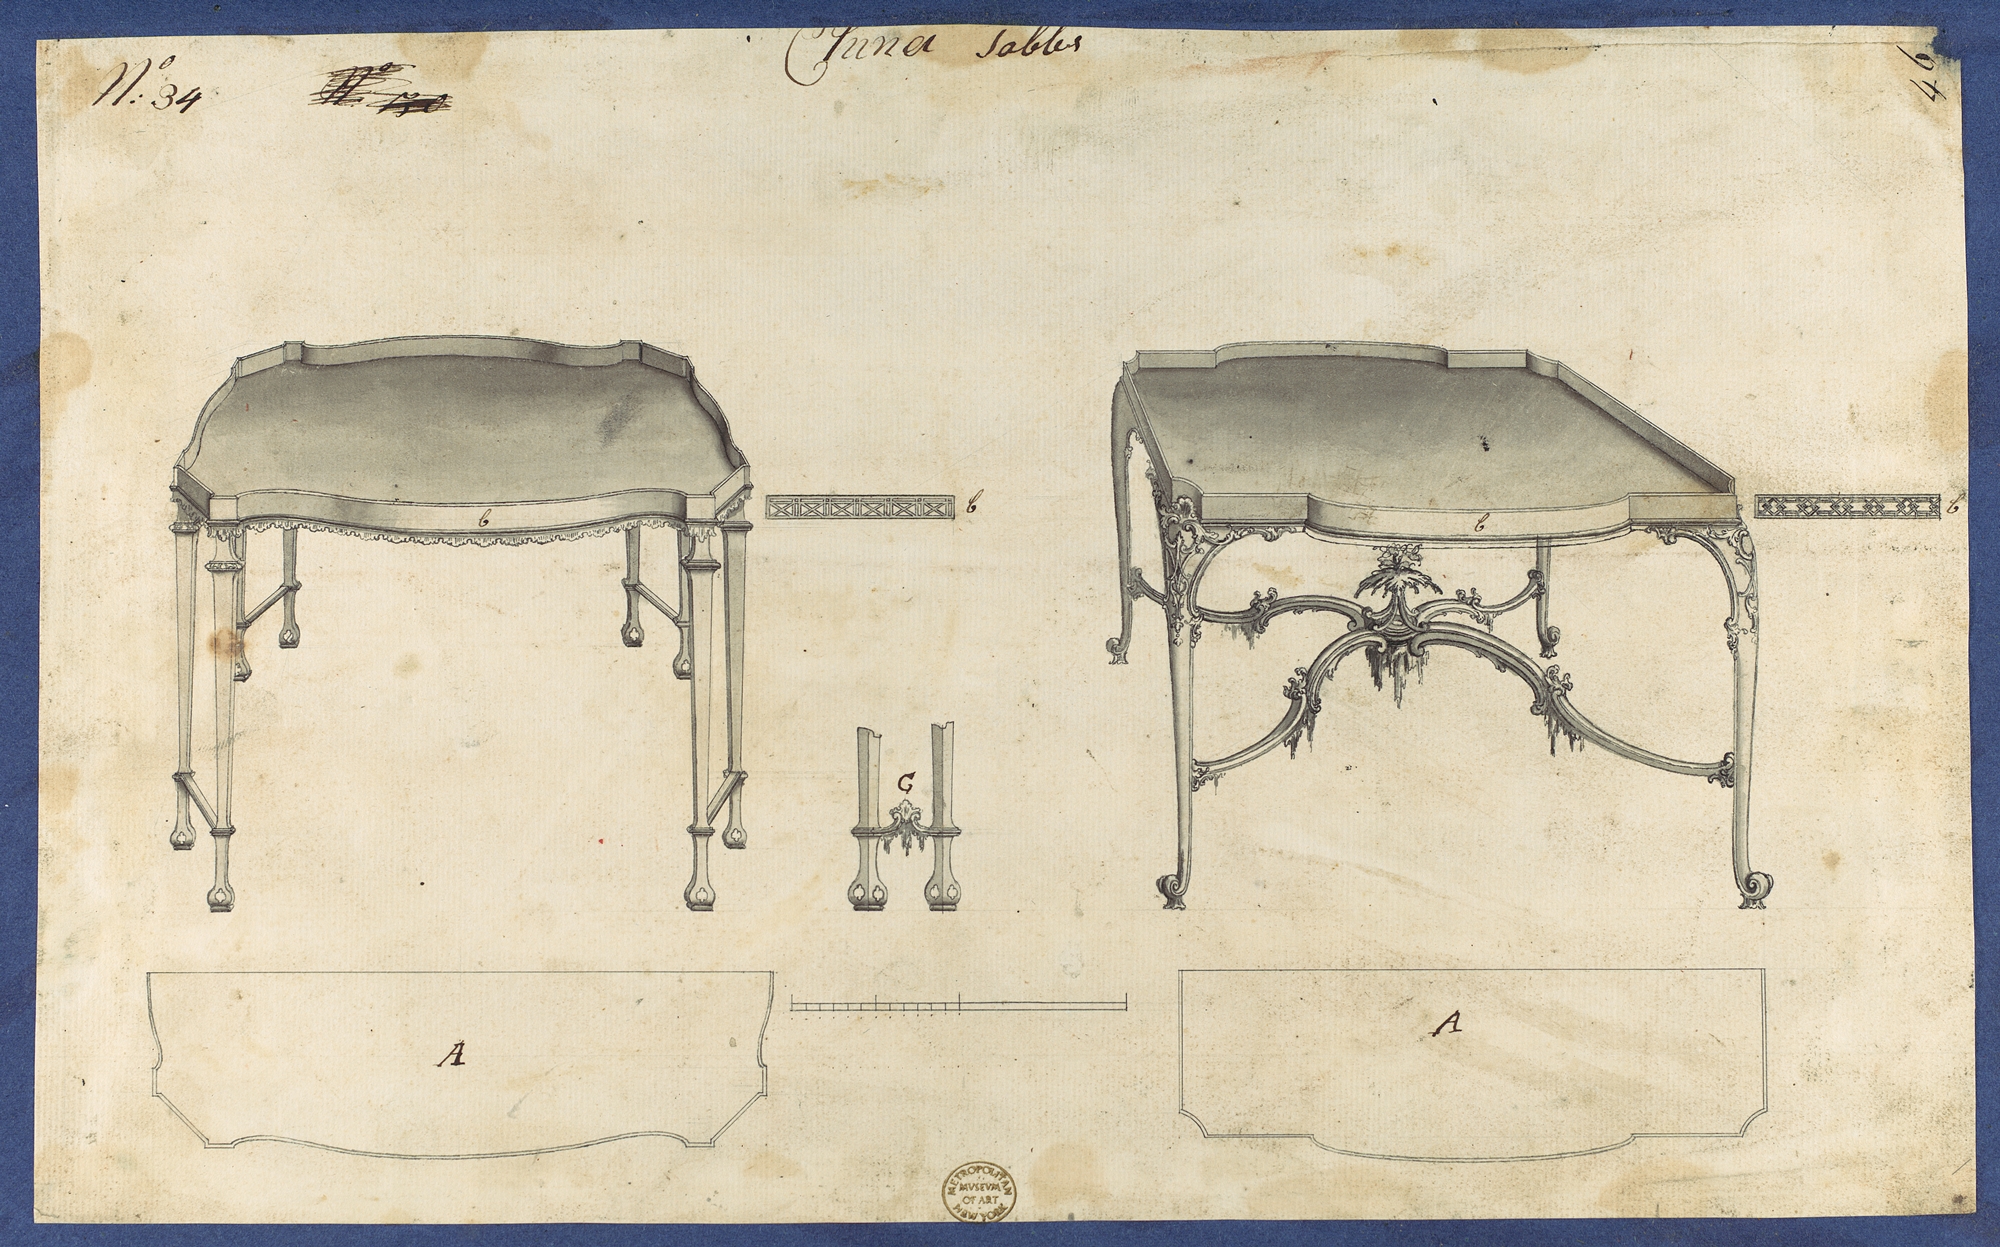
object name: drawing ornament architecture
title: China Tables, from Chippendale Drawings, Vol. II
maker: thomas chippendale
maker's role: artist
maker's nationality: british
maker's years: 1718-1779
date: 1754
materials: ink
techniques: wash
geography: london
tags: tables